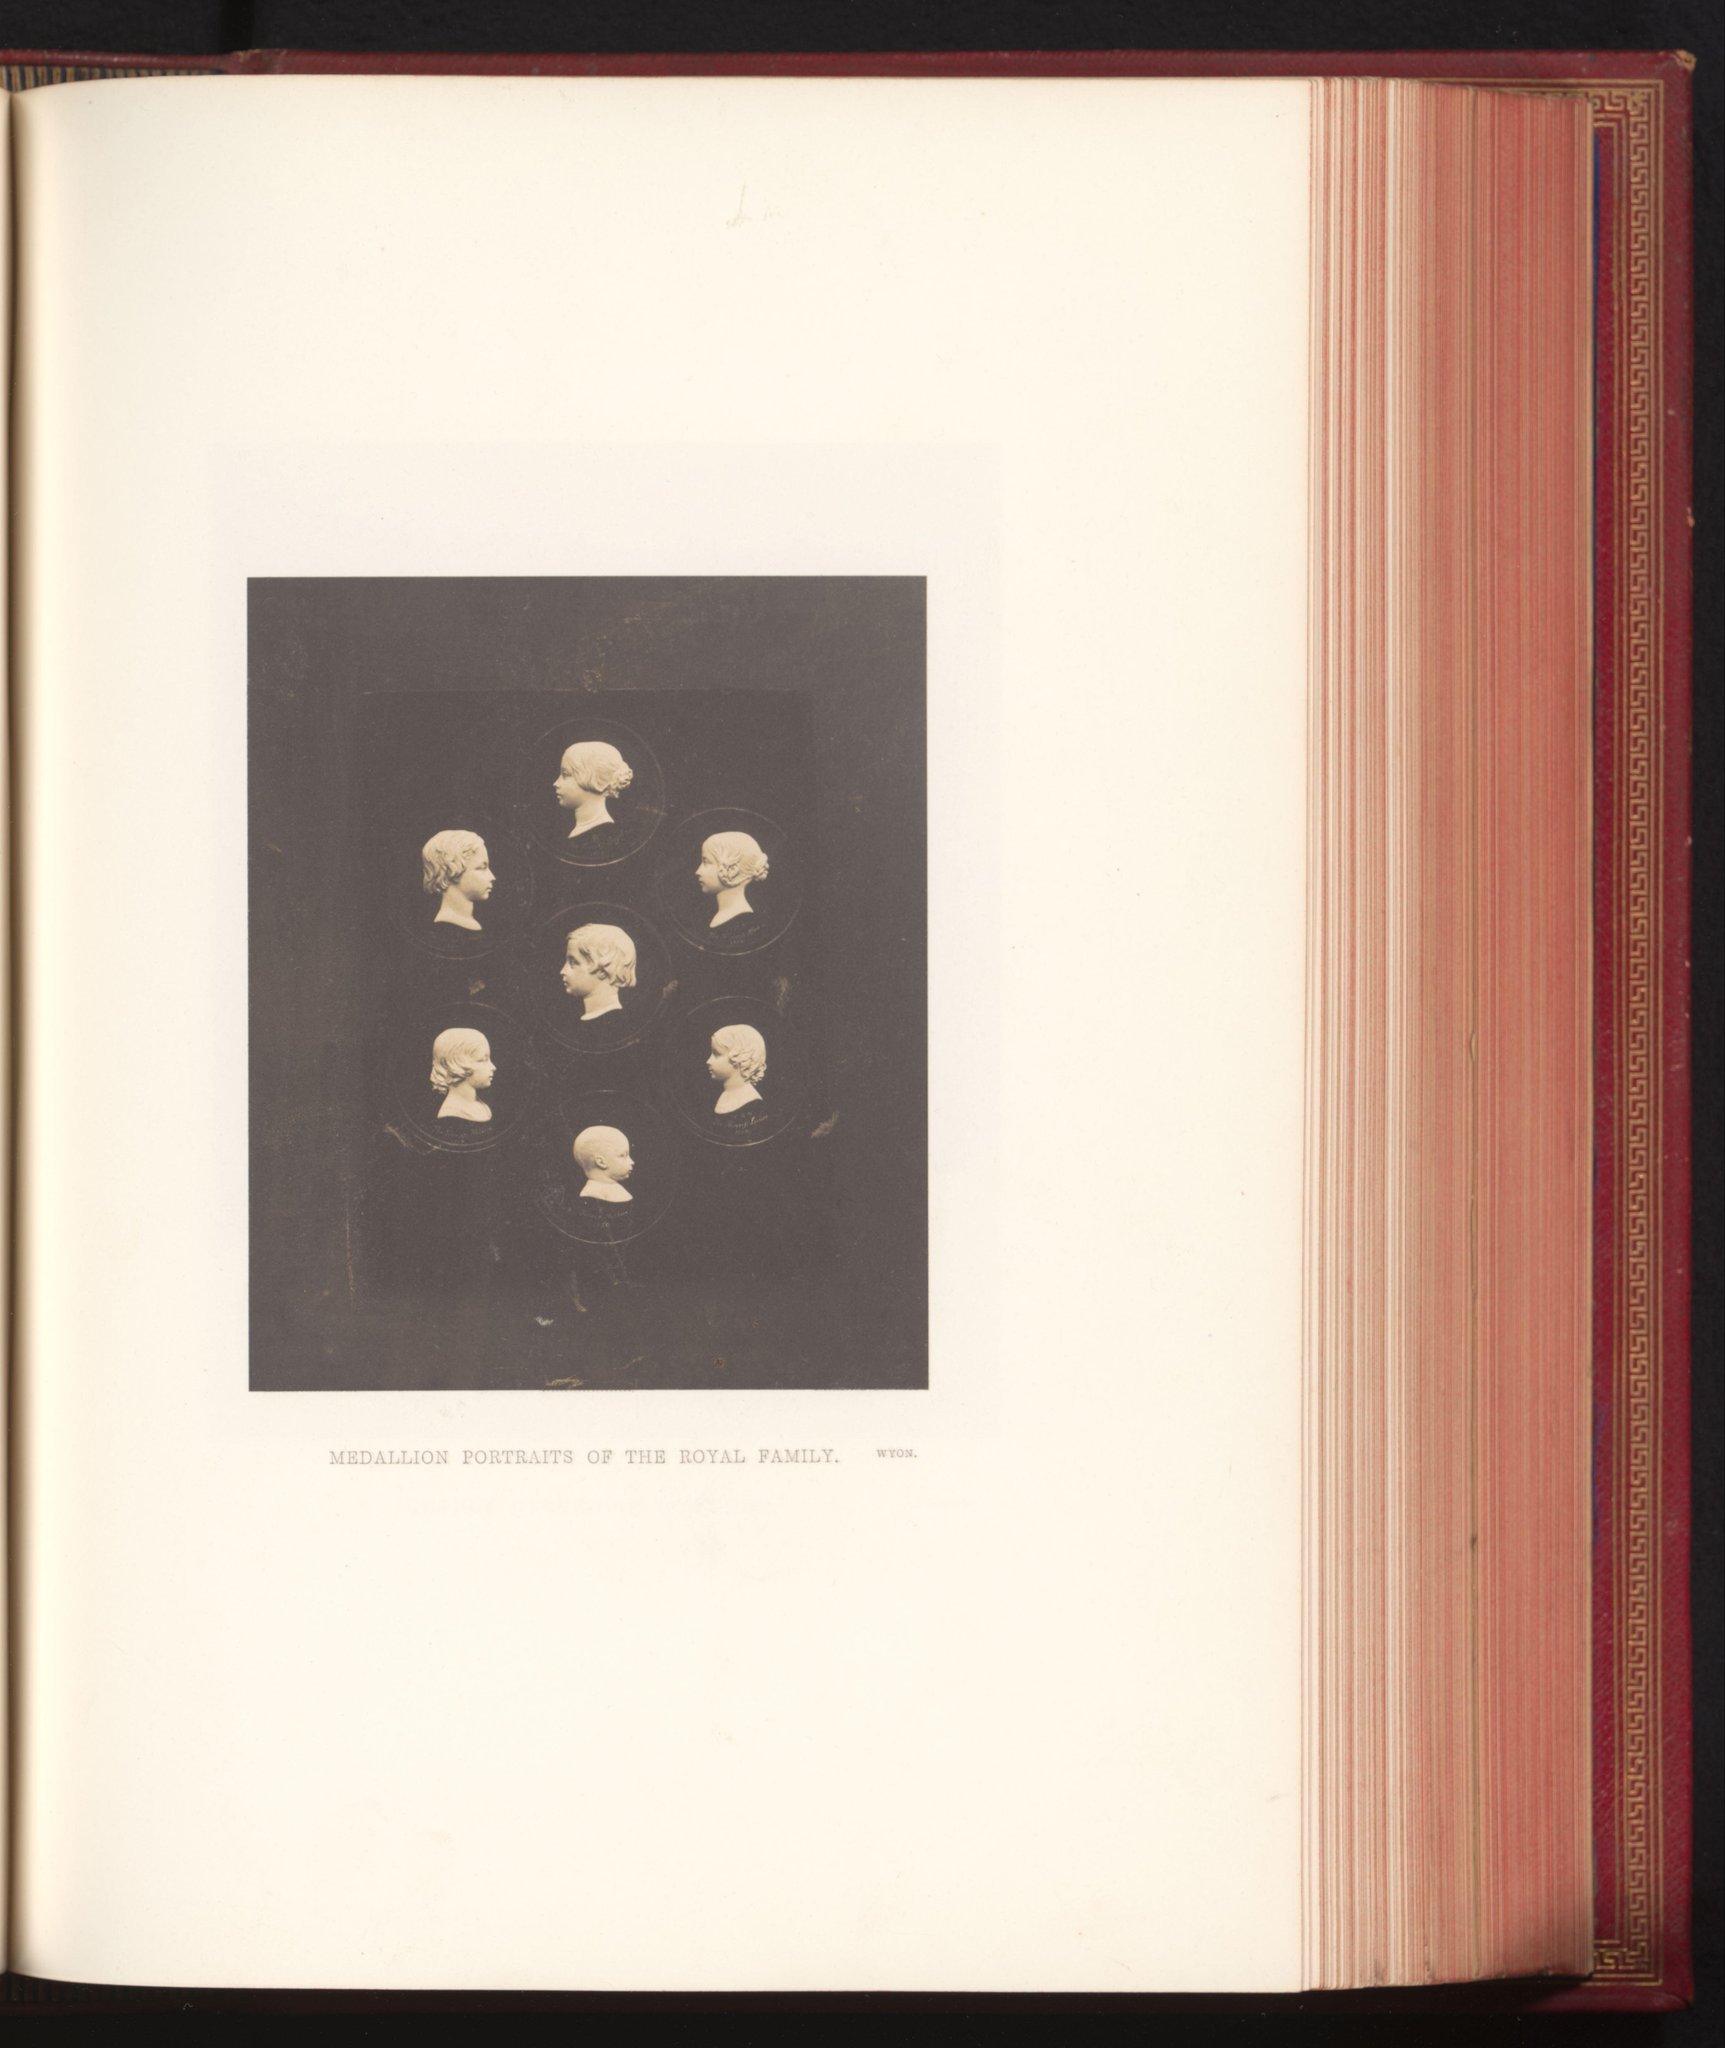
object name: page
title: Medaillon Portraits of the Royal Family. Wyon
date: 1851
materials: photographic support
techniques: salted paper print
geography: london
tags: ornament ~ medallion, london